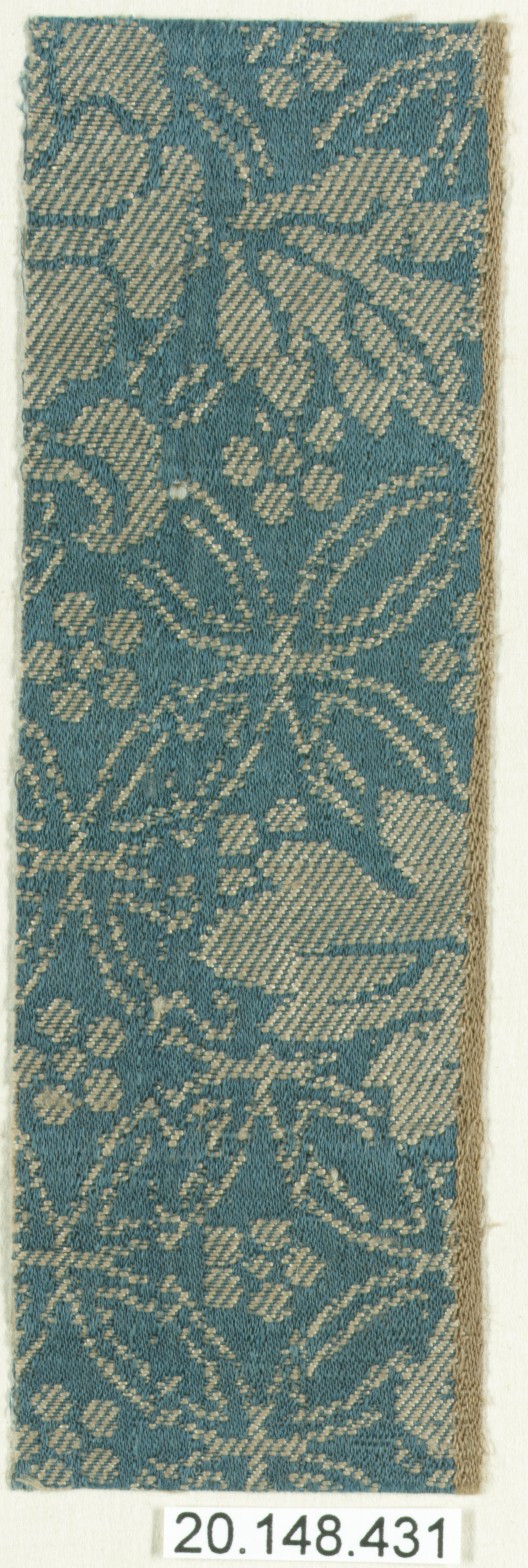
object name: piece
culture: japanese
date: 1701-1800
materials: silk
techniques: compound weave